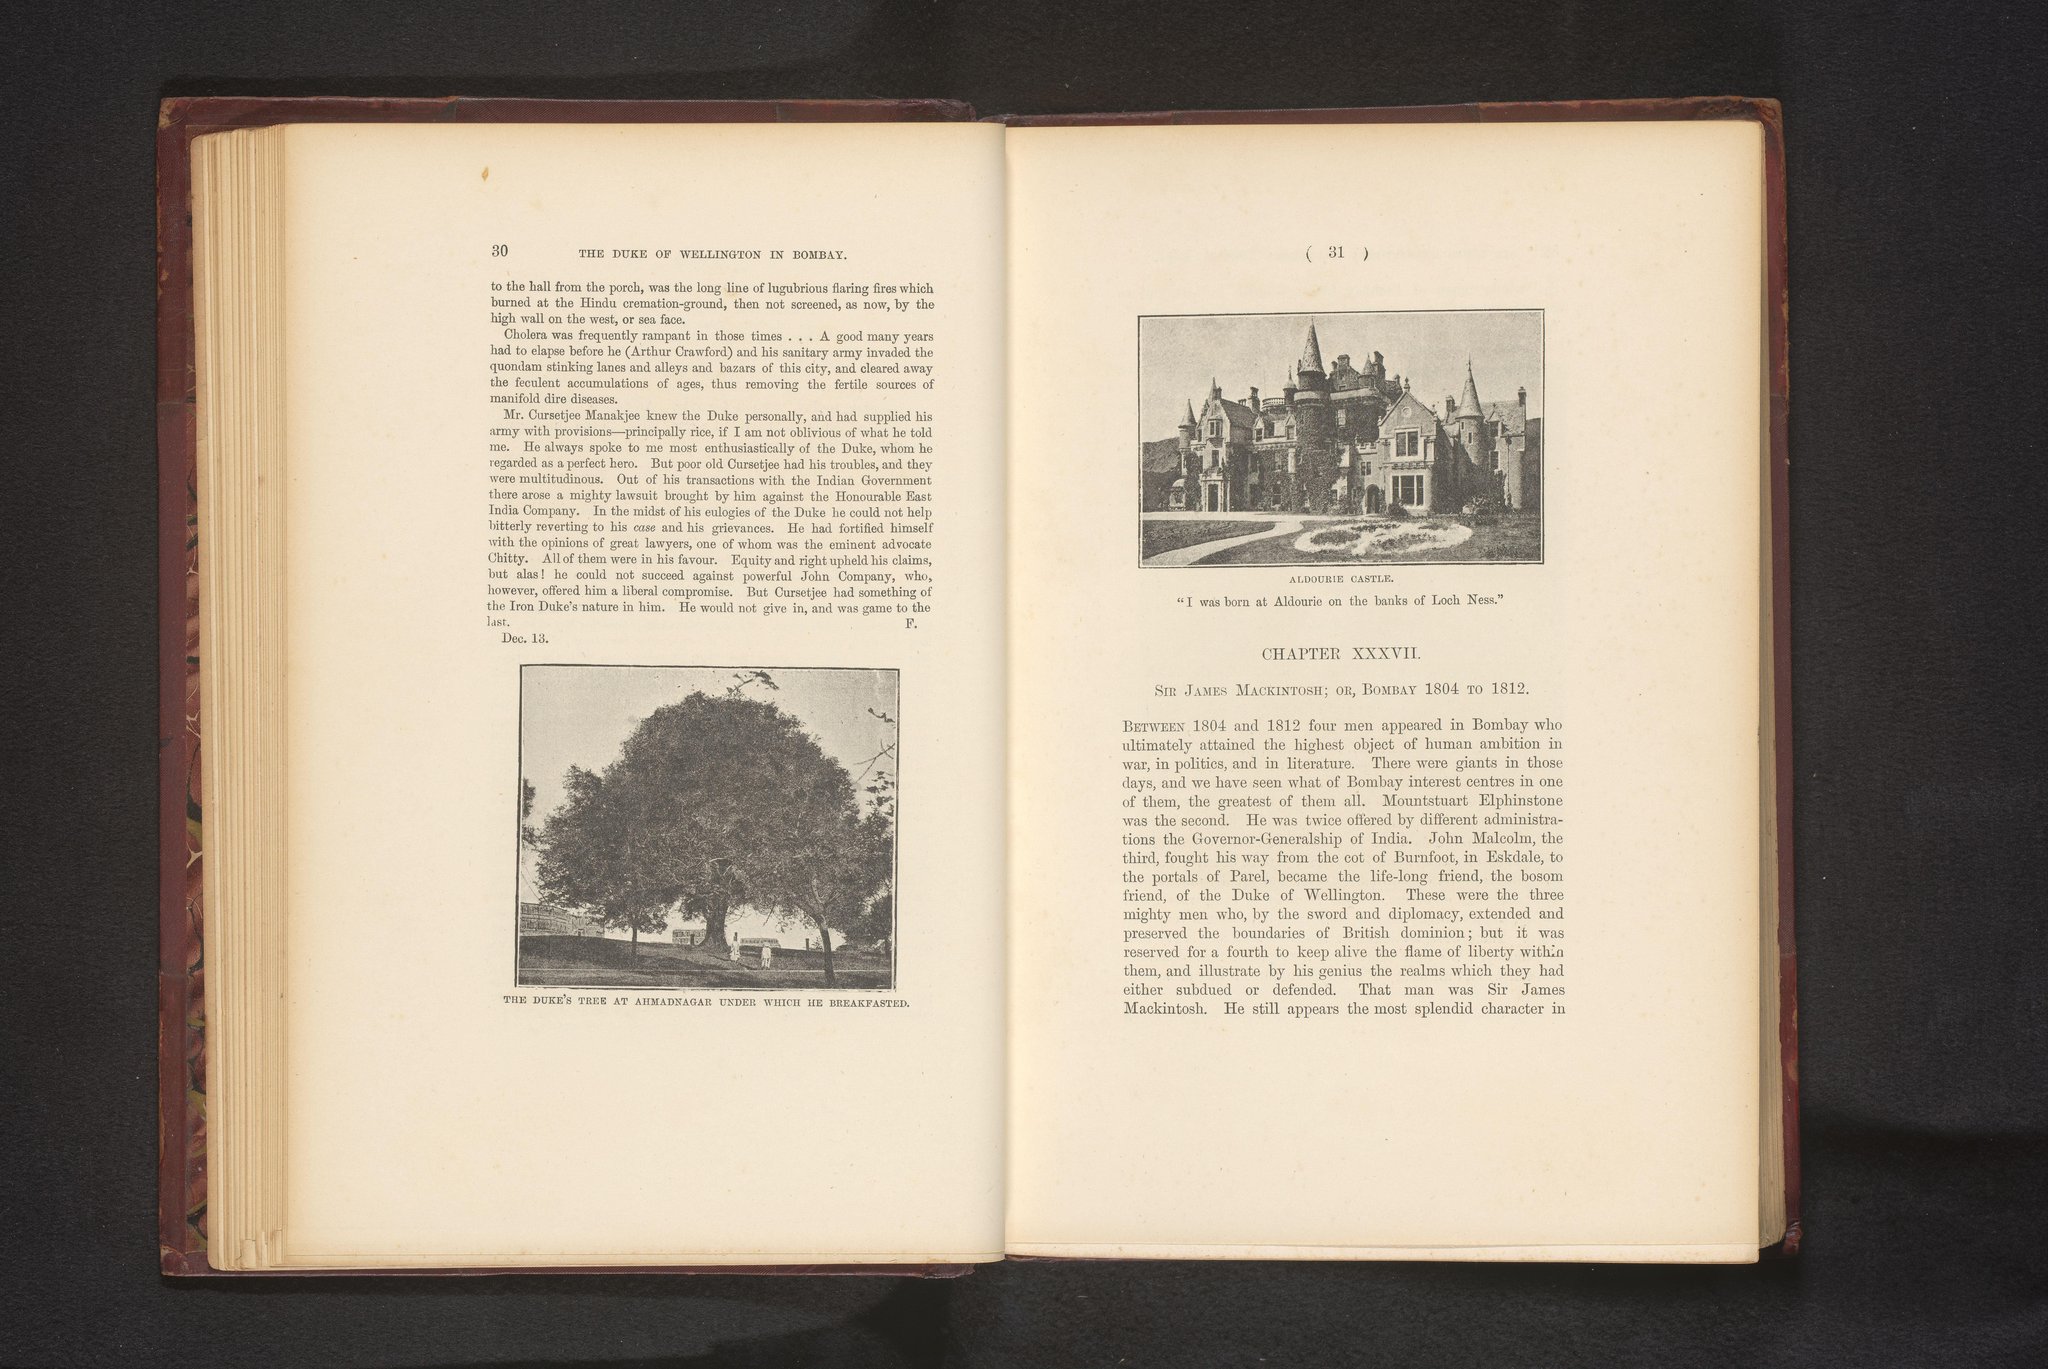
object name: page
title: Aldourie Castle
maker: Anonymous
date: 1883-1893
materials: paper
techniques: autotype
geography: aldourie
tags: castle, façade (of house or building)